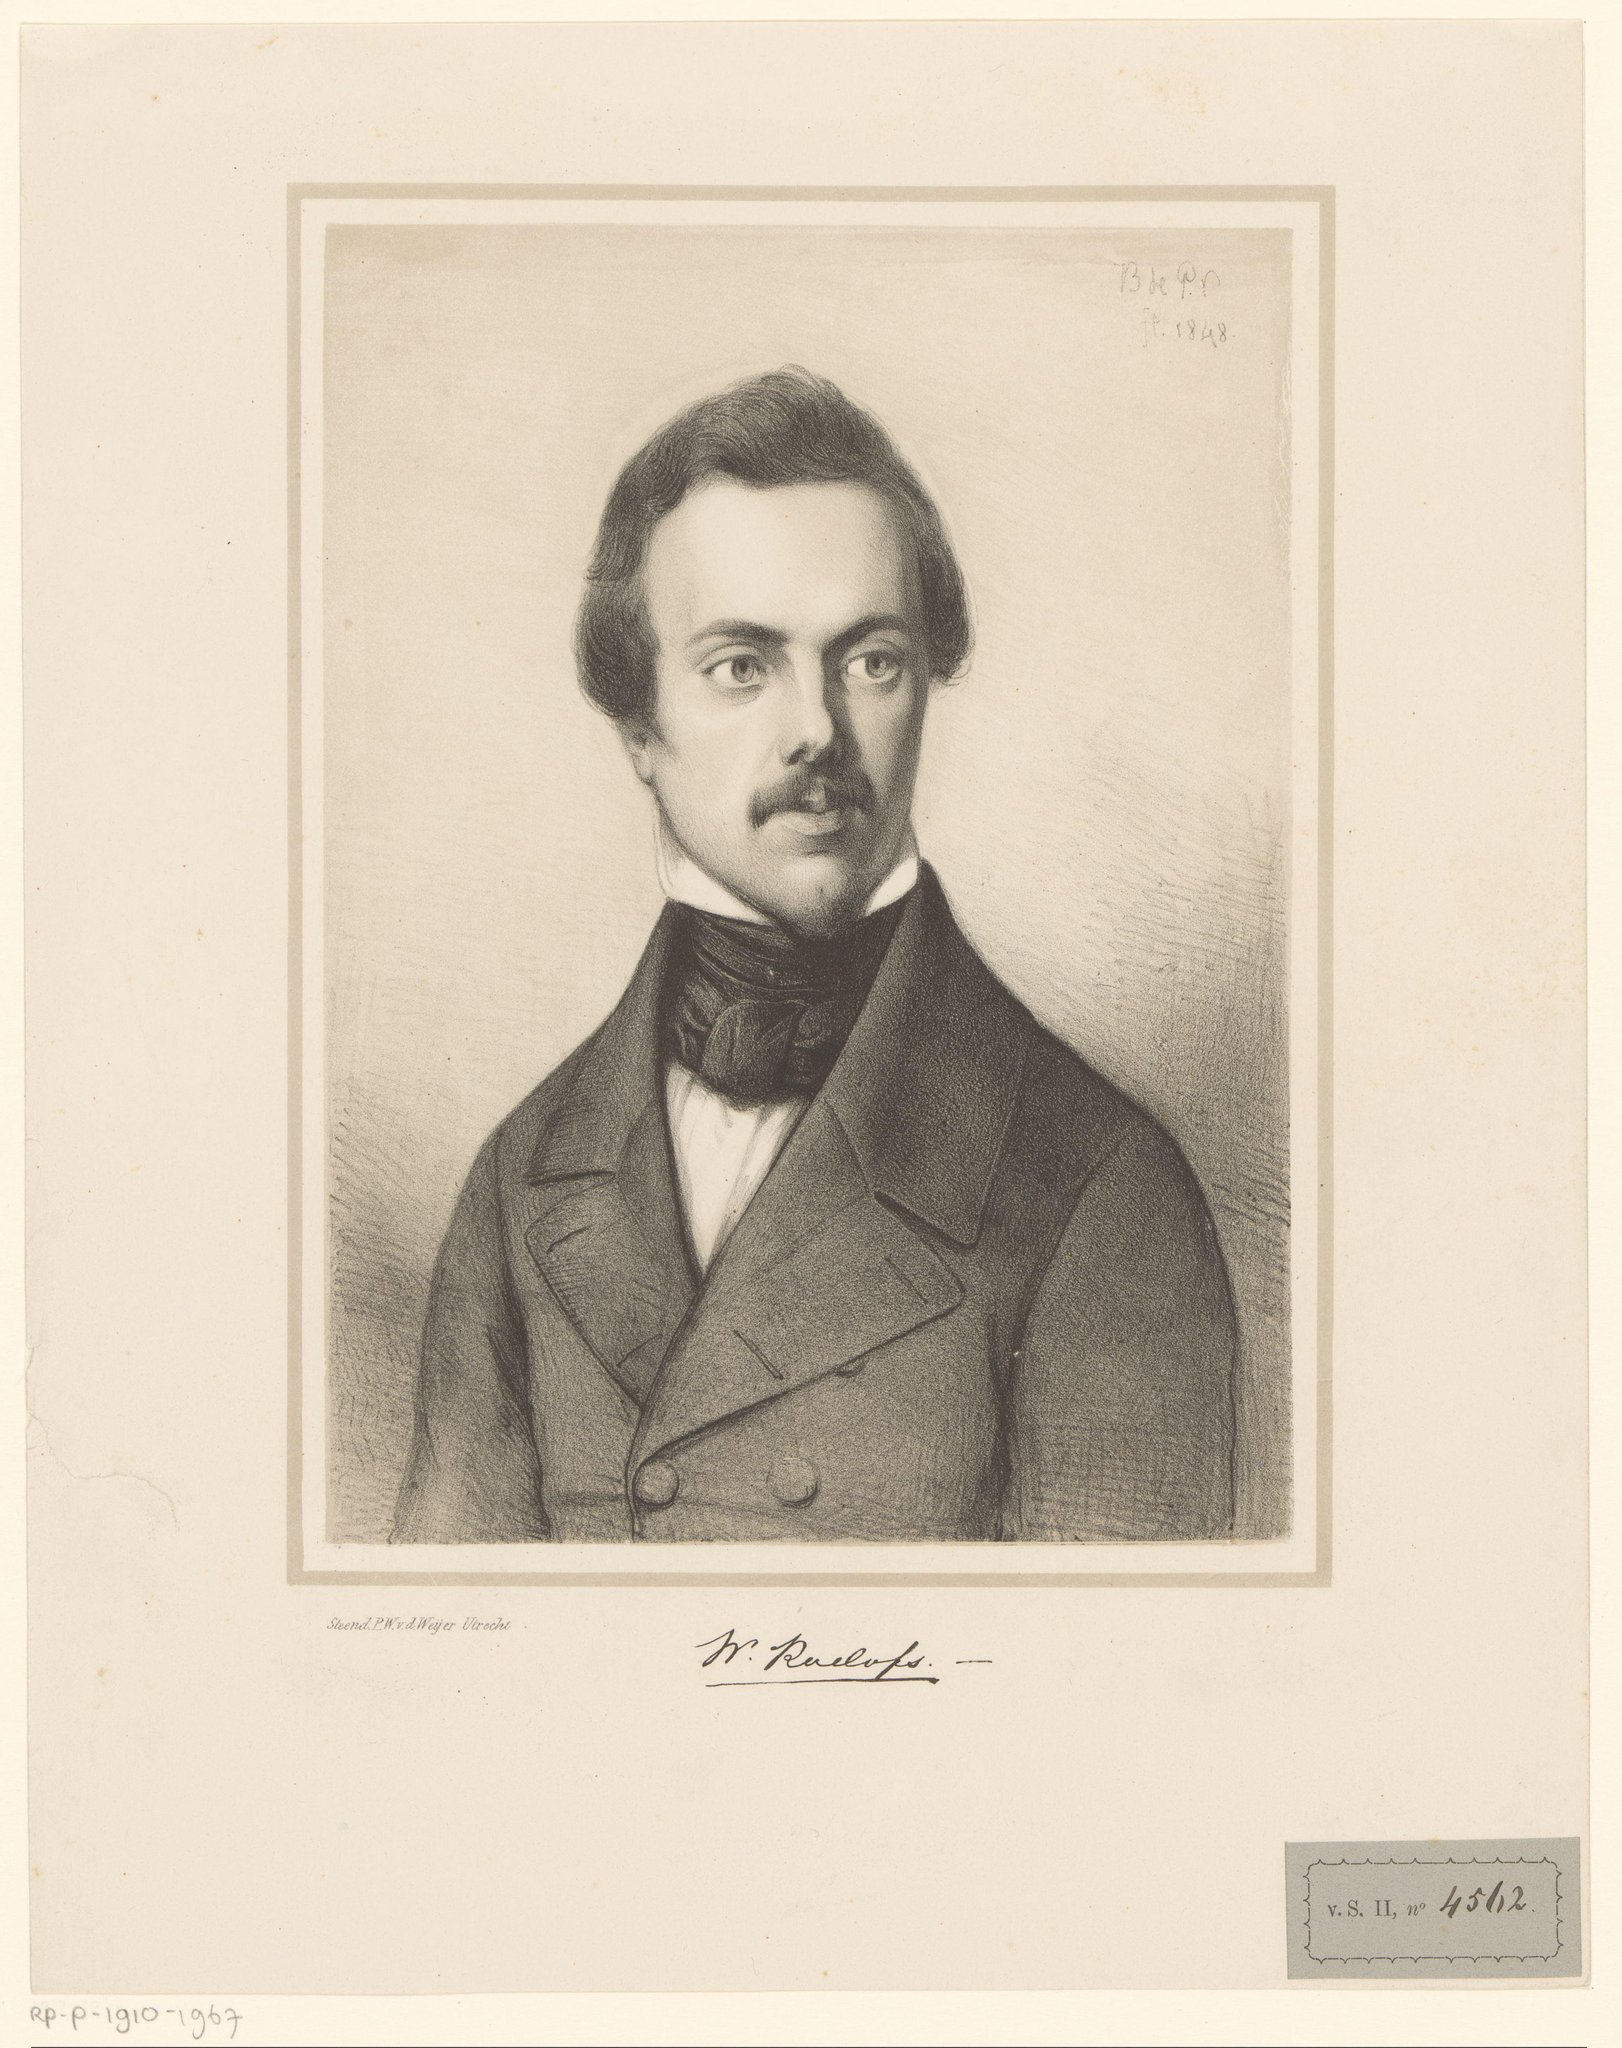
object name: print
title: Portret van Willem Roelofs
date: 1848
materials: paper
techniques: tone lithography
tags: amsterdam, painter, draughtsman, willem roelofs (i), historical persons (+ (full) bust portrait)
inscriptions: collector's mark: Lugt 2228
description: Onder het portret de signatuur van de geportretteerde.